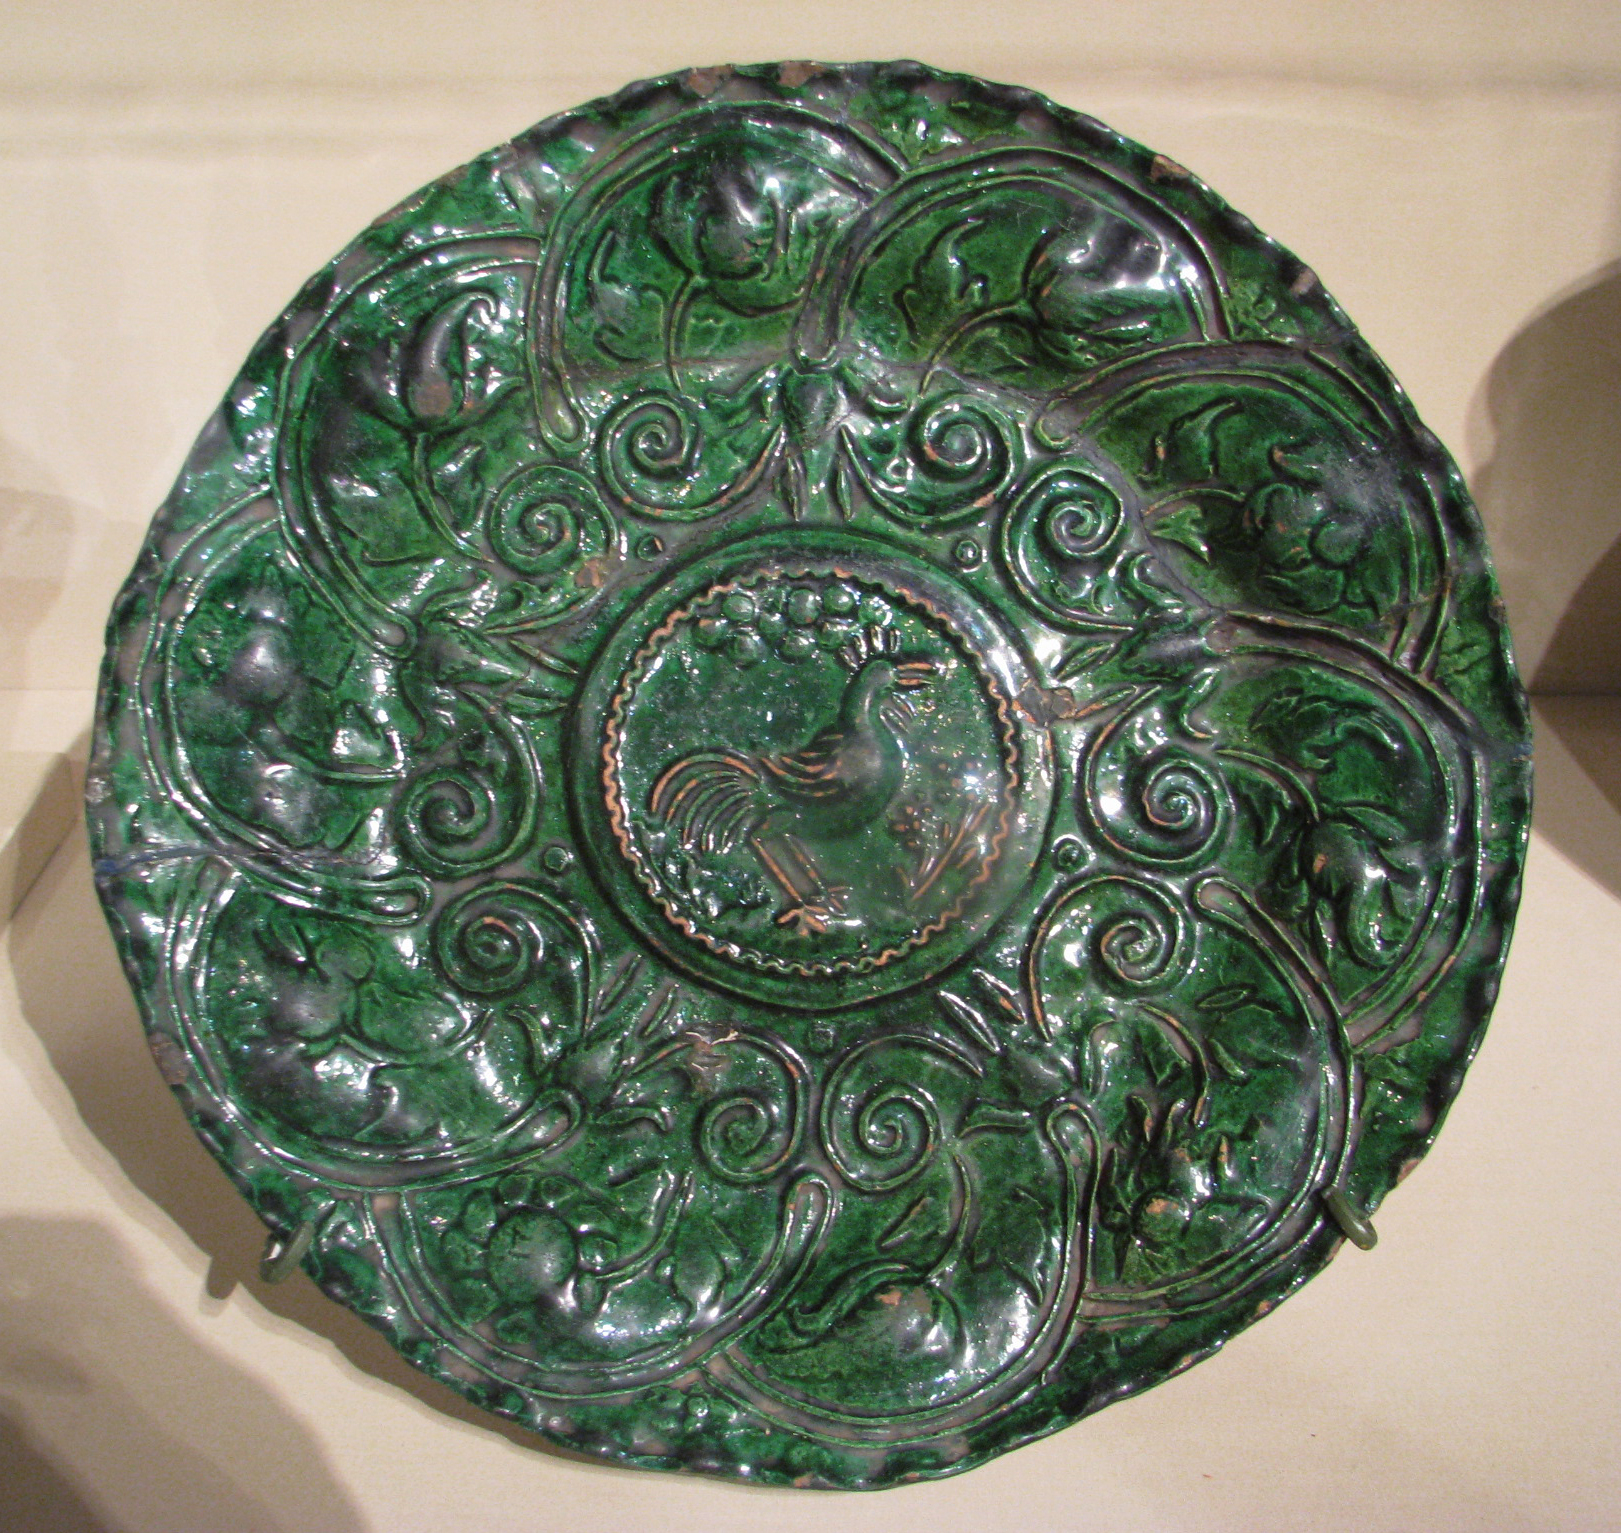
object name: plate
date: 1651-1700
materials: earthenware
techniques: glazing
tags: roosters